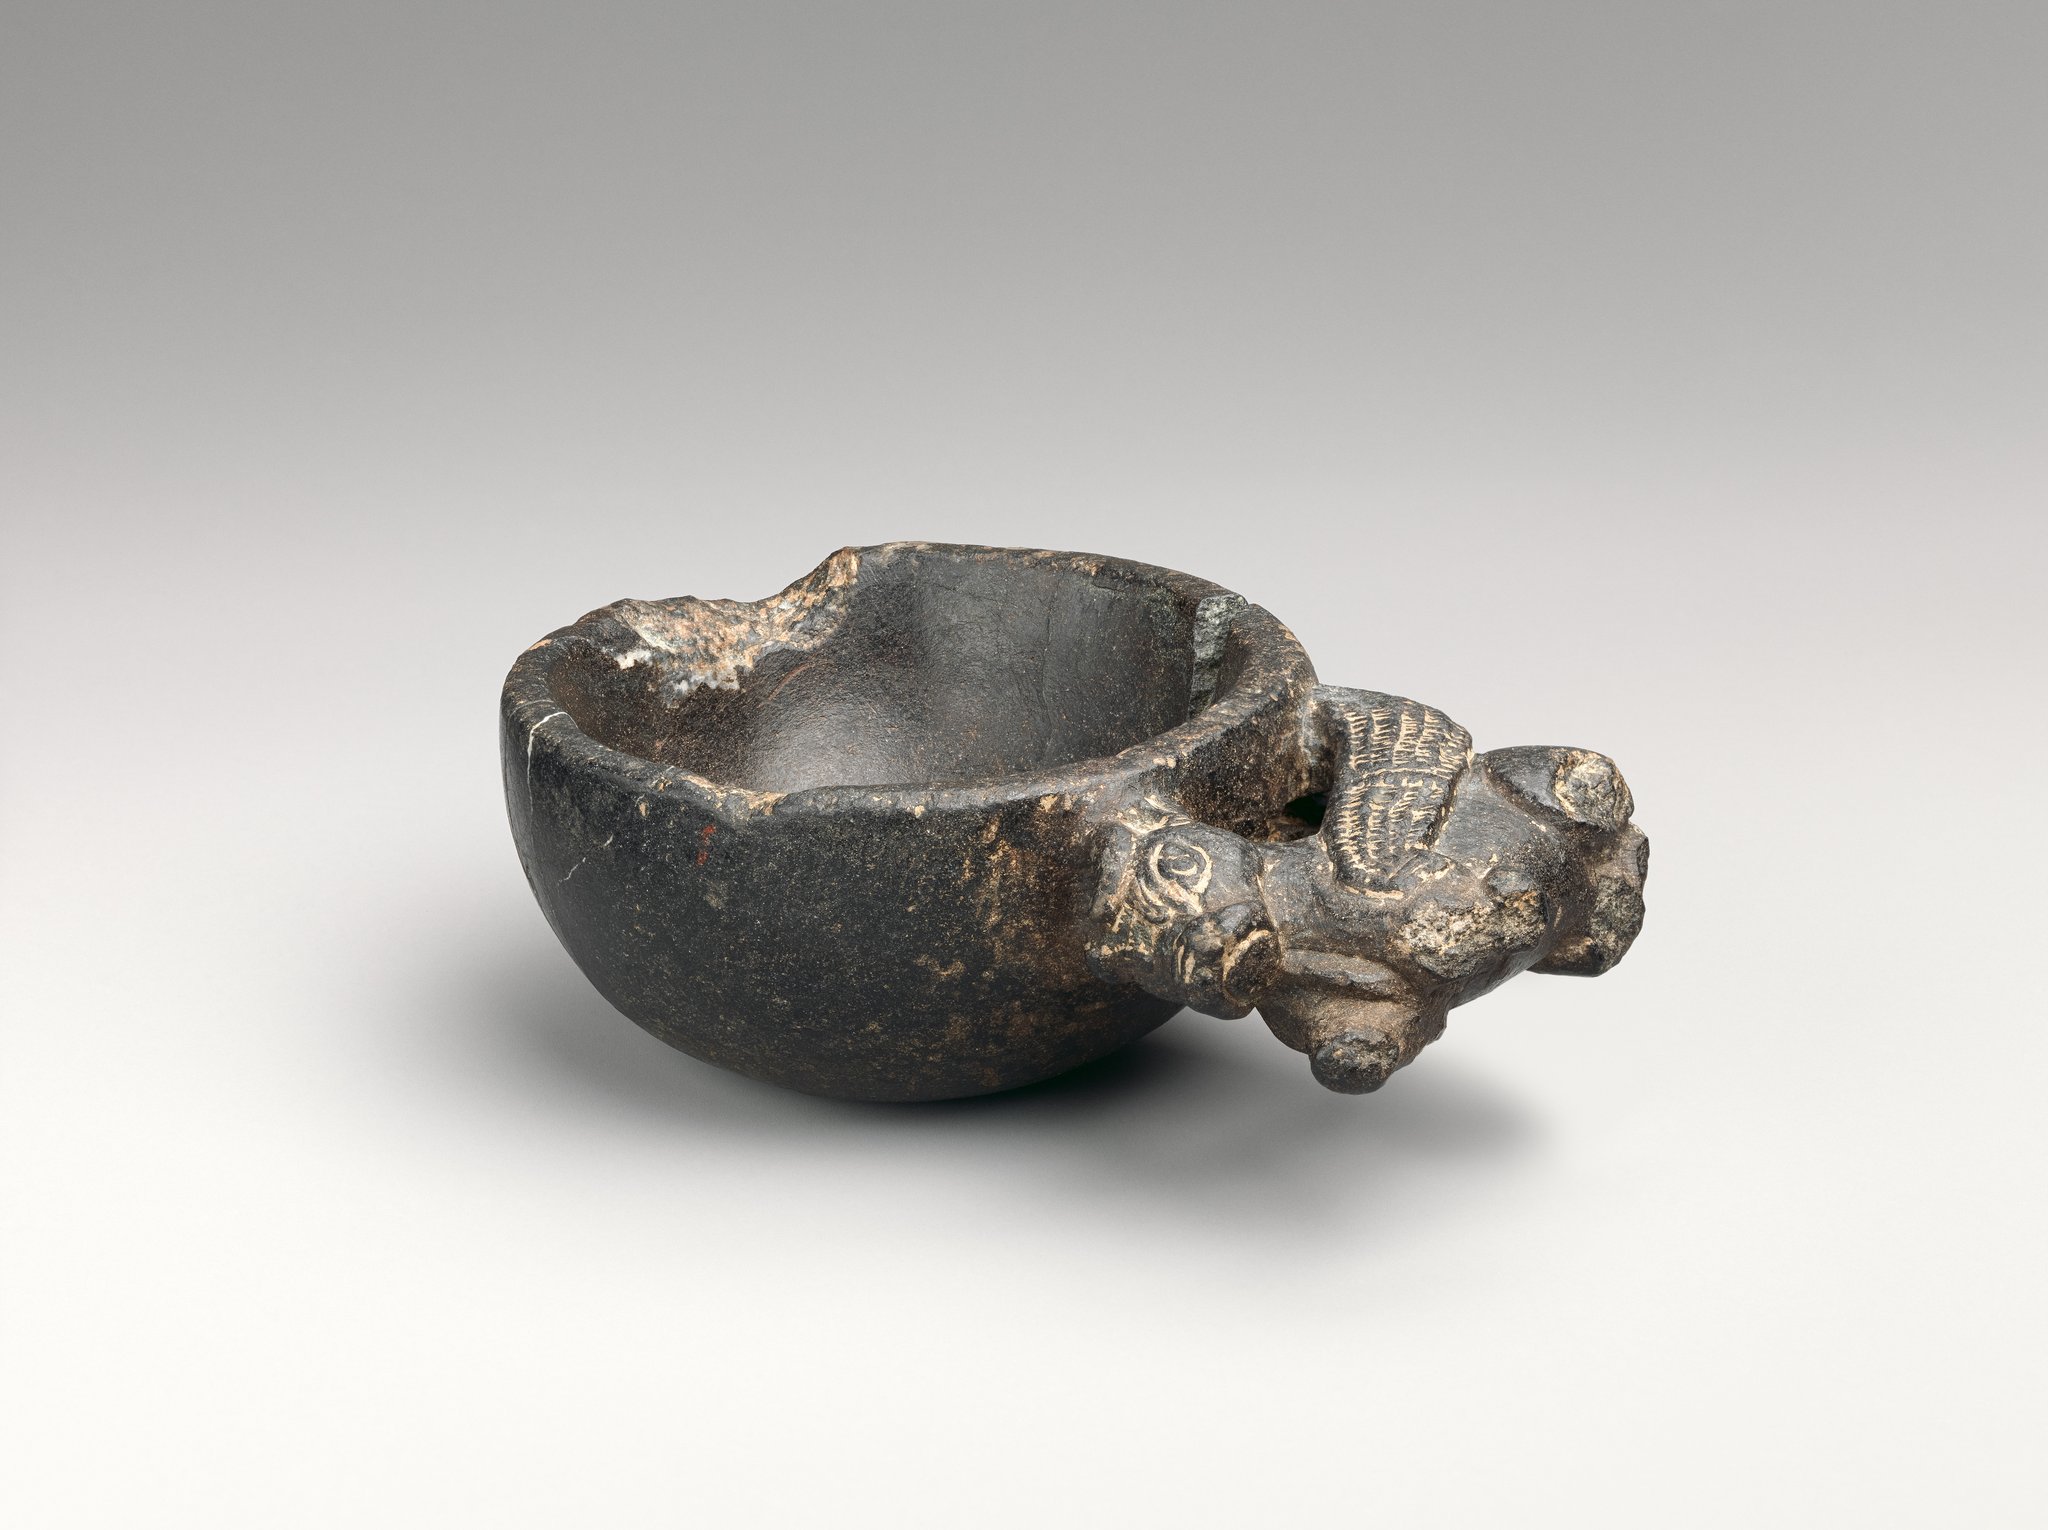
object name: bowl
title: Bowl with a handle in the form of a winged bull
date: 800-701 BCE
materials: mineral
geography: northern syria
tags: bulls